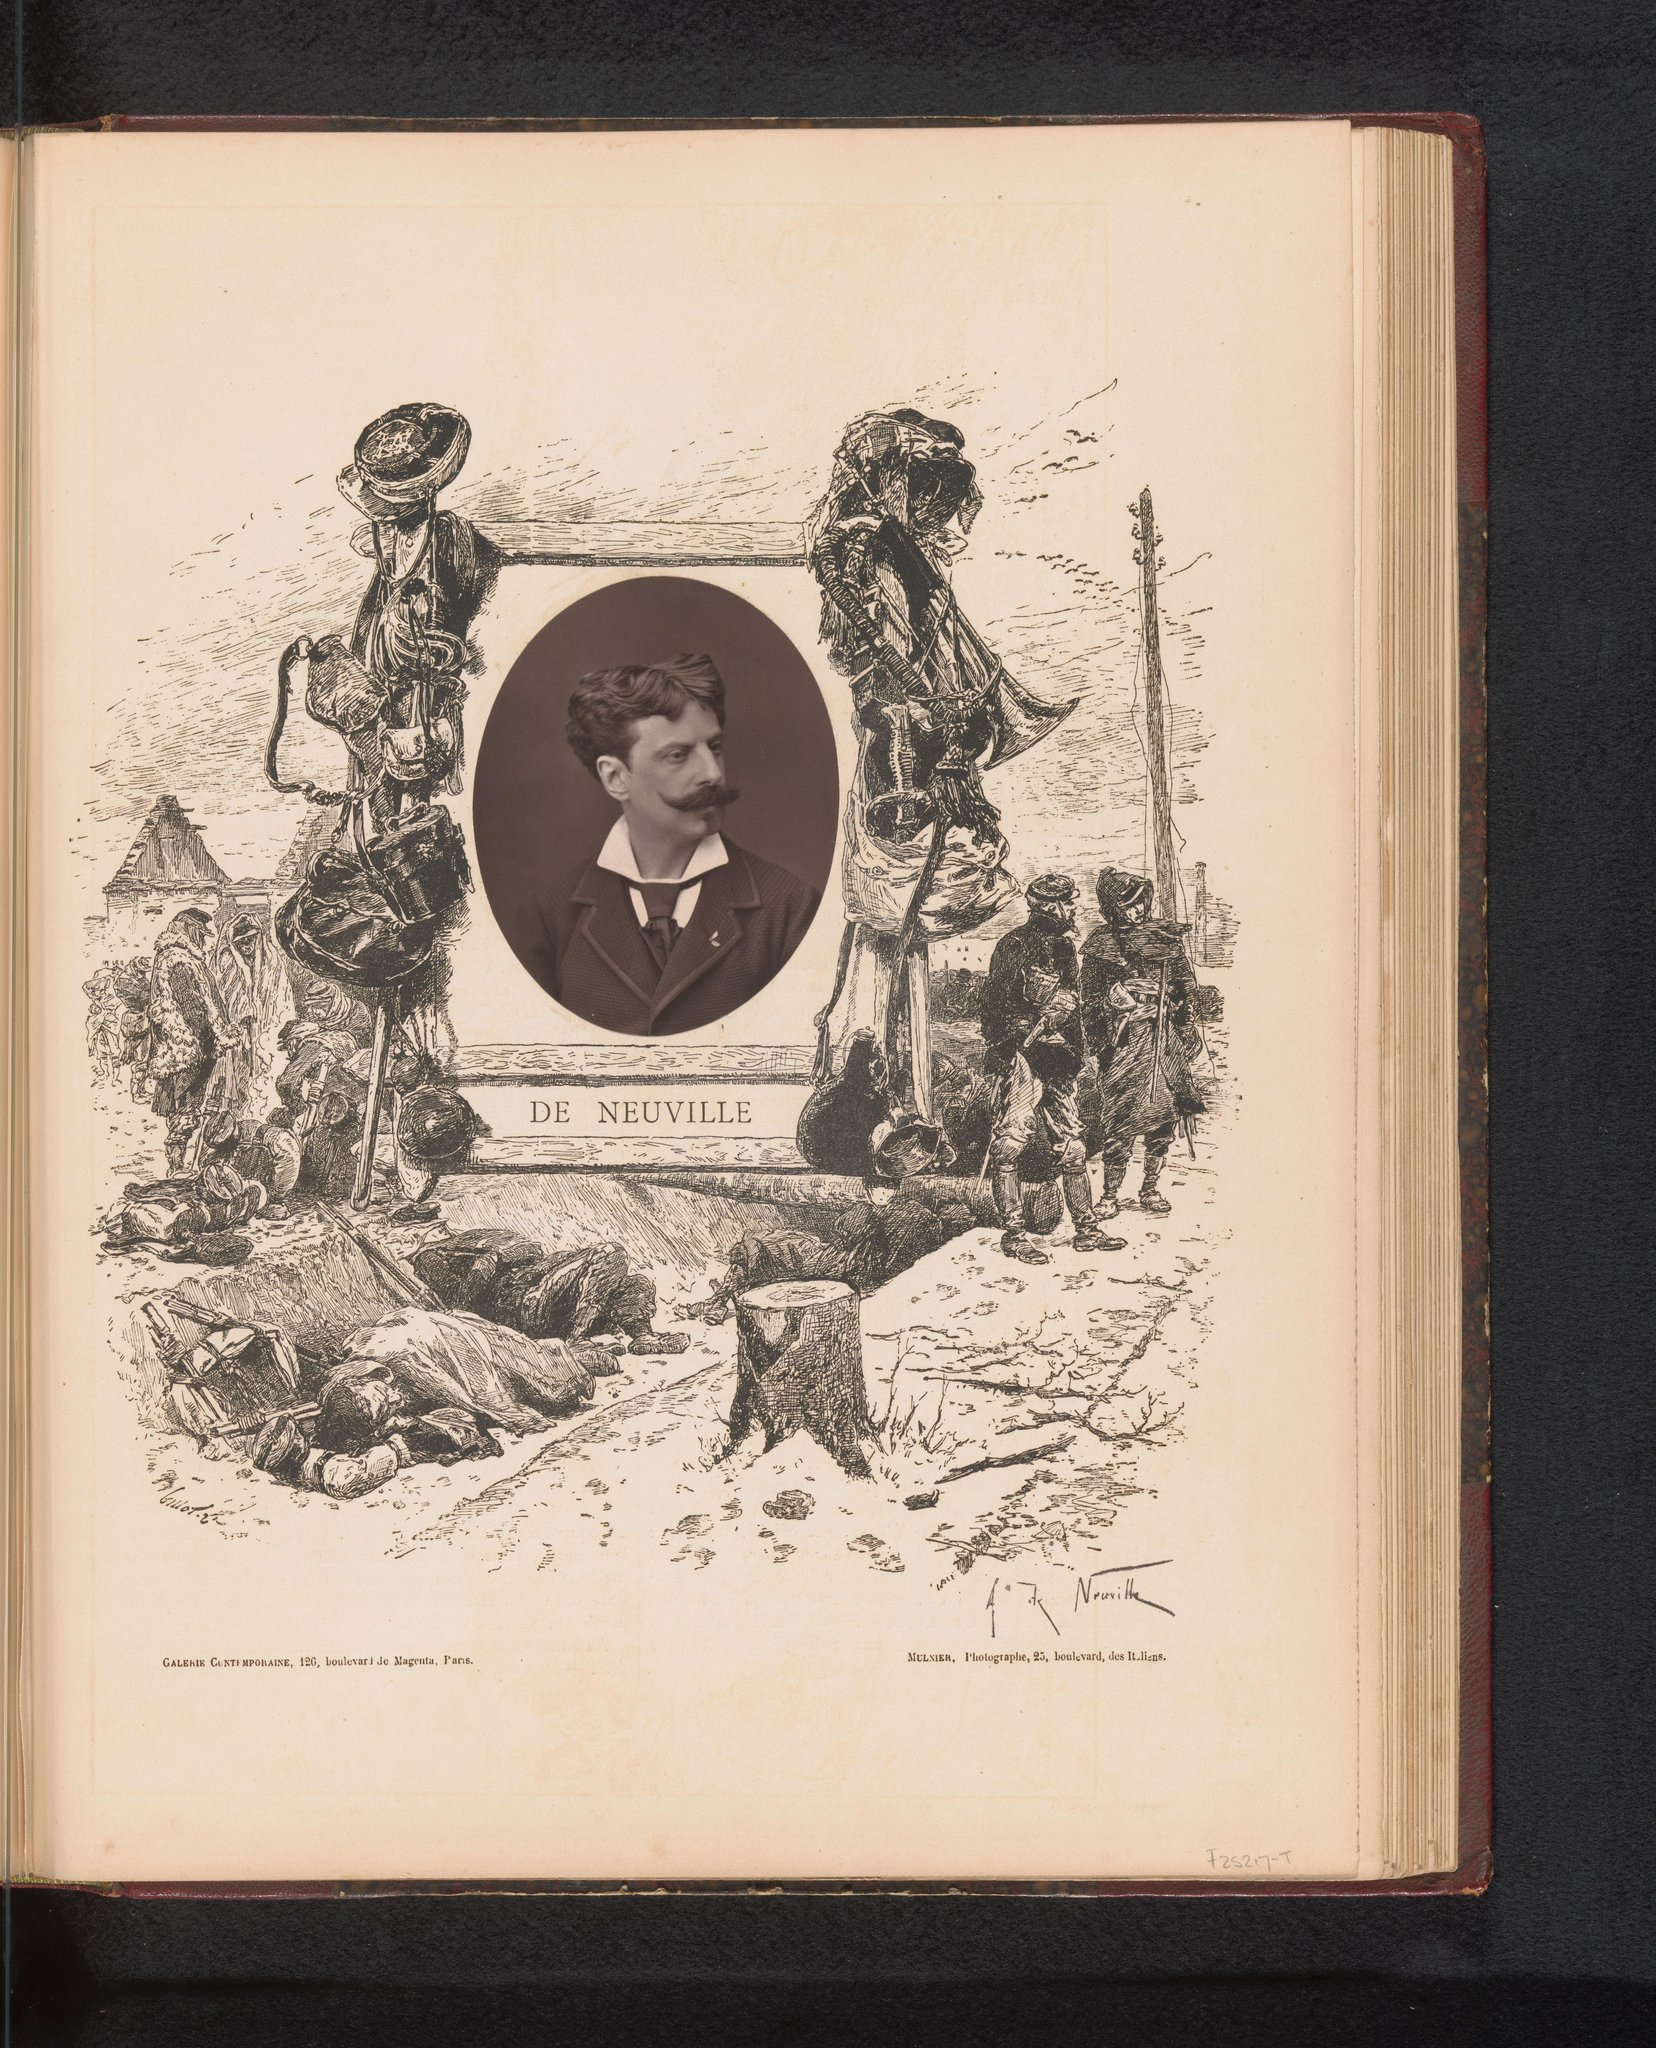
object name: photomechanical print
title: Portret van Alphonse de Neuville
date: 1867-1877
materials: paper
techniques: printing block, woodburytype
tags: paris, painter, alphonse de neuville, adult man, historical persons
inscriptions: inscription: ‘Galerie Contemporaine, 126, boulevard de Magenta.’